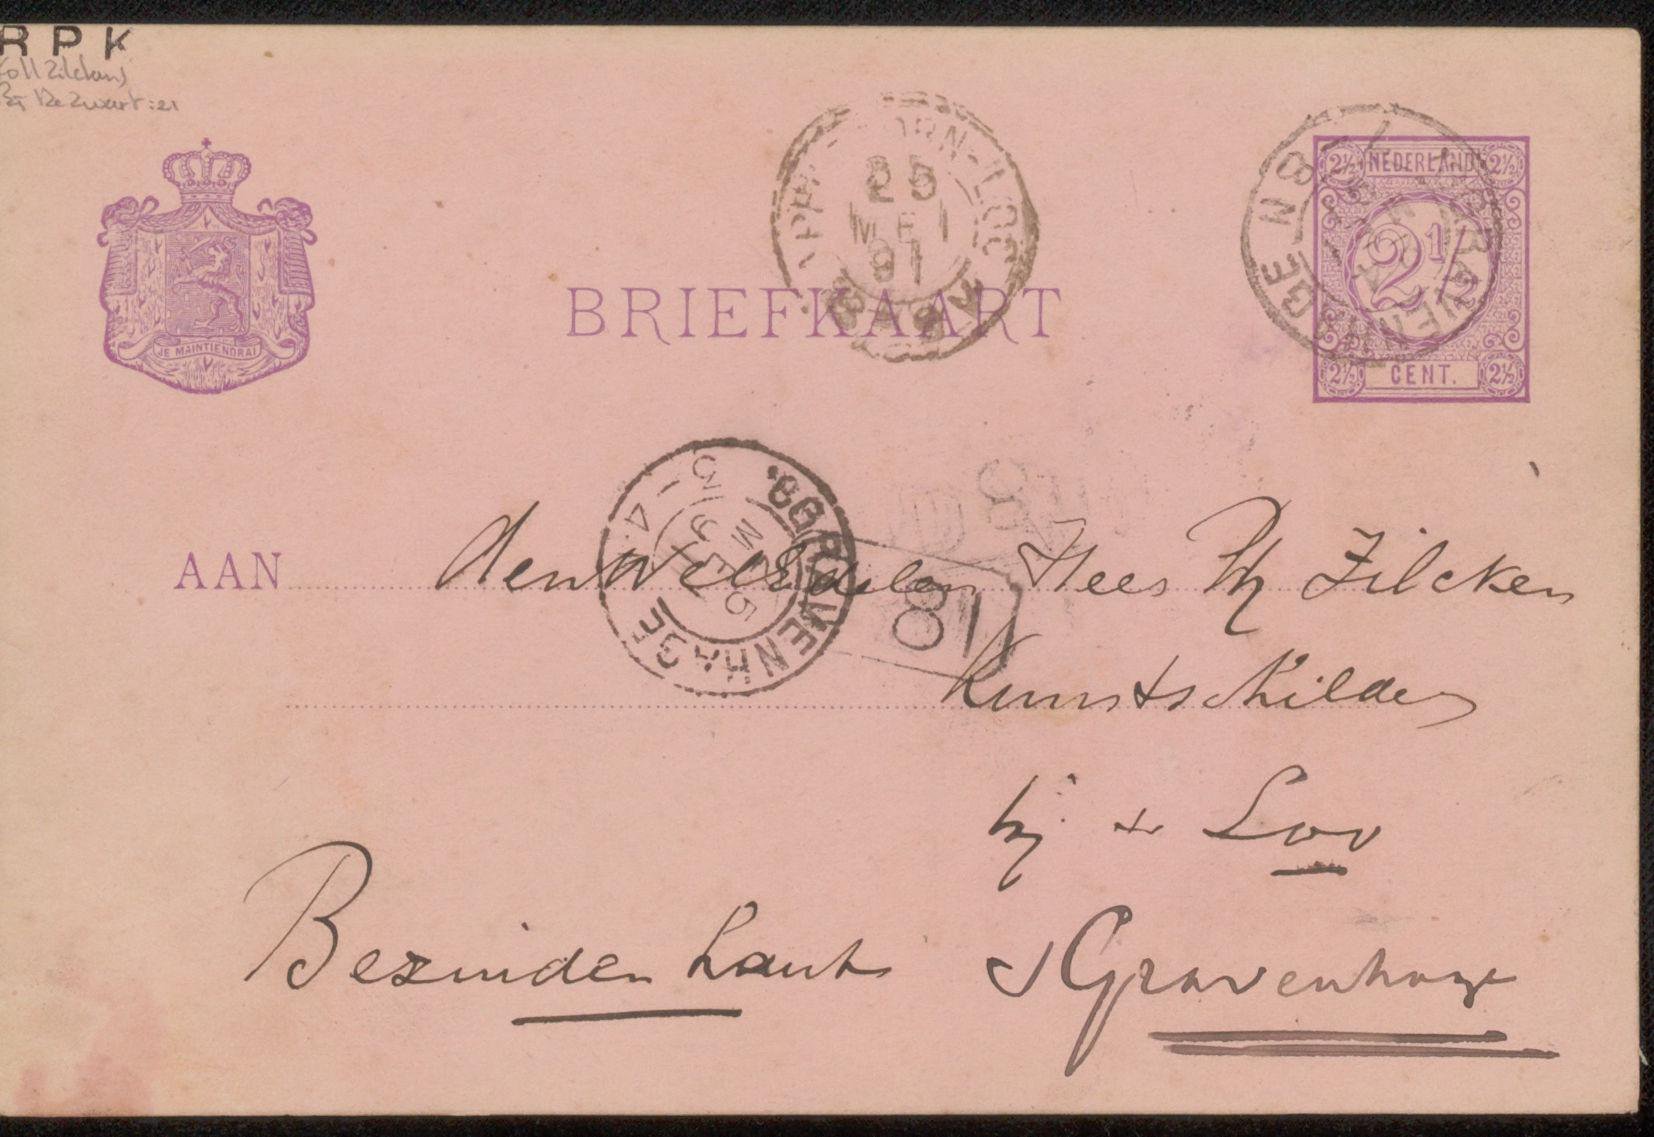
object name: postcard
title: Briefkaart aan Philip Zilcken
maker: willem de zwart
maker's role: draughtsman, painter, print maker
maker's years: 1862-1931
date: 1891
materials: cardboard, ink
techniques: pen, writing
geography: the hague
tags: the hague, painter, draughtsman, philip zilcken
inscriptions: collector's mark: ‘RPK’